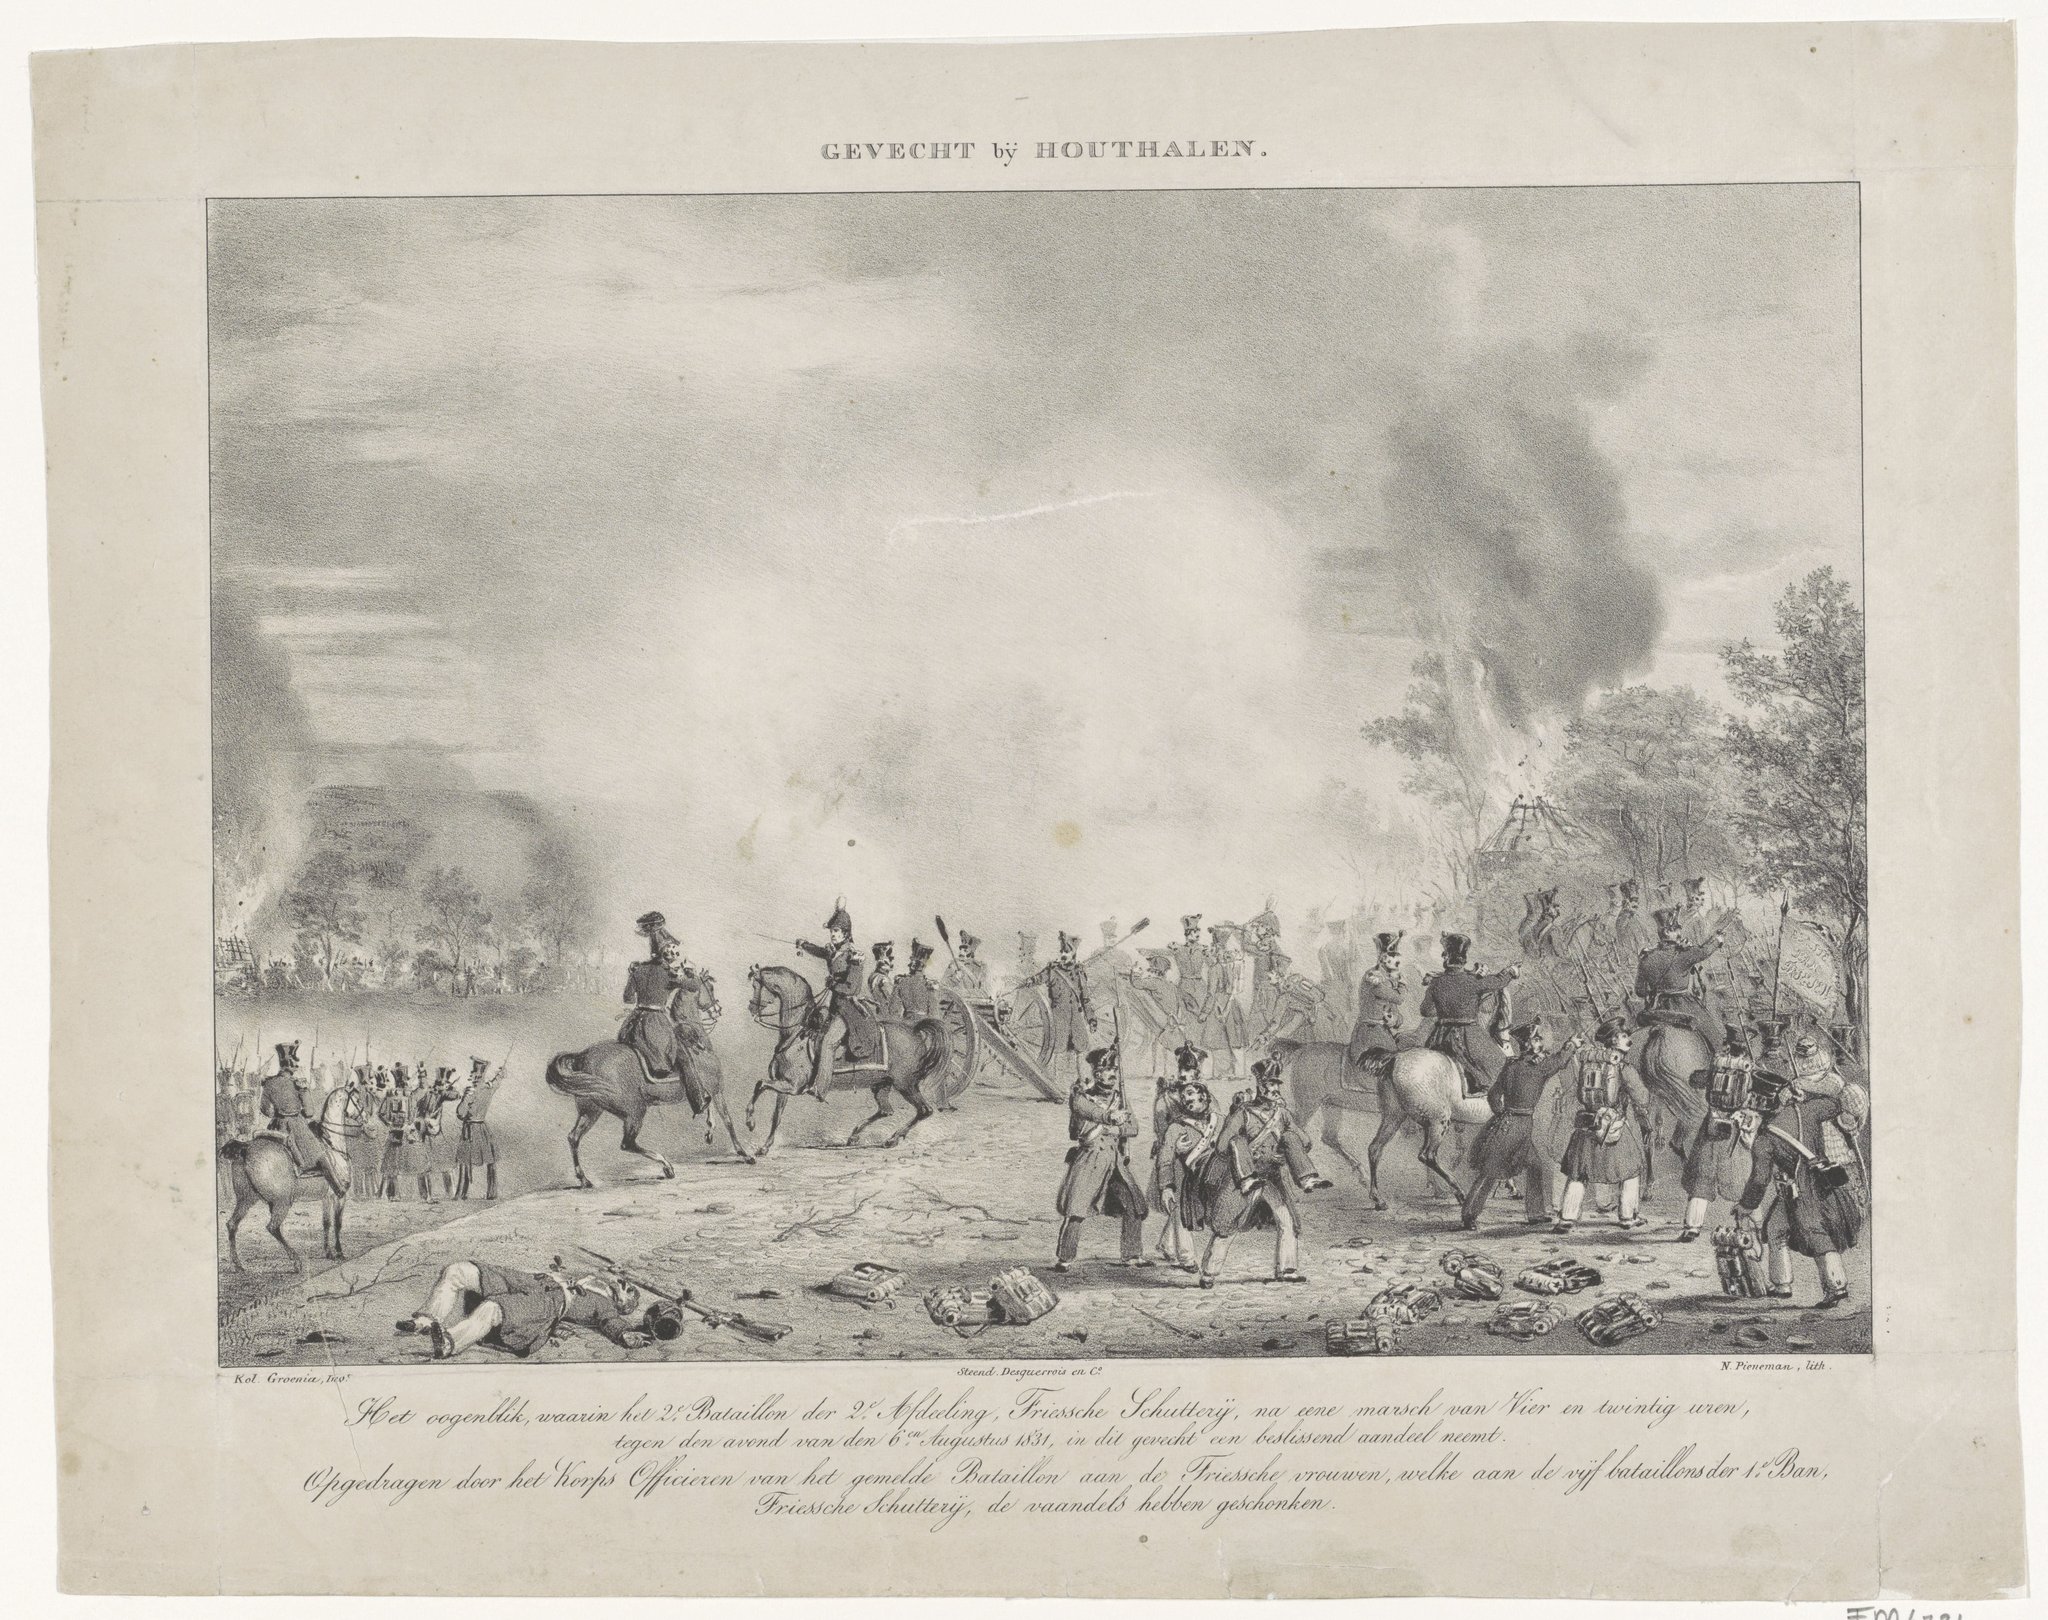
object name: print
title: Slag bij Houthalen, 1831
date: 1831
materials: paper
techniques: lithograph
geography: netherlands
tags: battle (+ land forces)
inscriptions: collector's mark: Lugt 2228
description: De slag bij Houthalen op 6 augustus 1831, op het moment dat de 2e Afdeling Friese Schutterij arriveert op het slagveld en een beslissende rol in het gevecht speelt. Met vierregelig onderschrift.